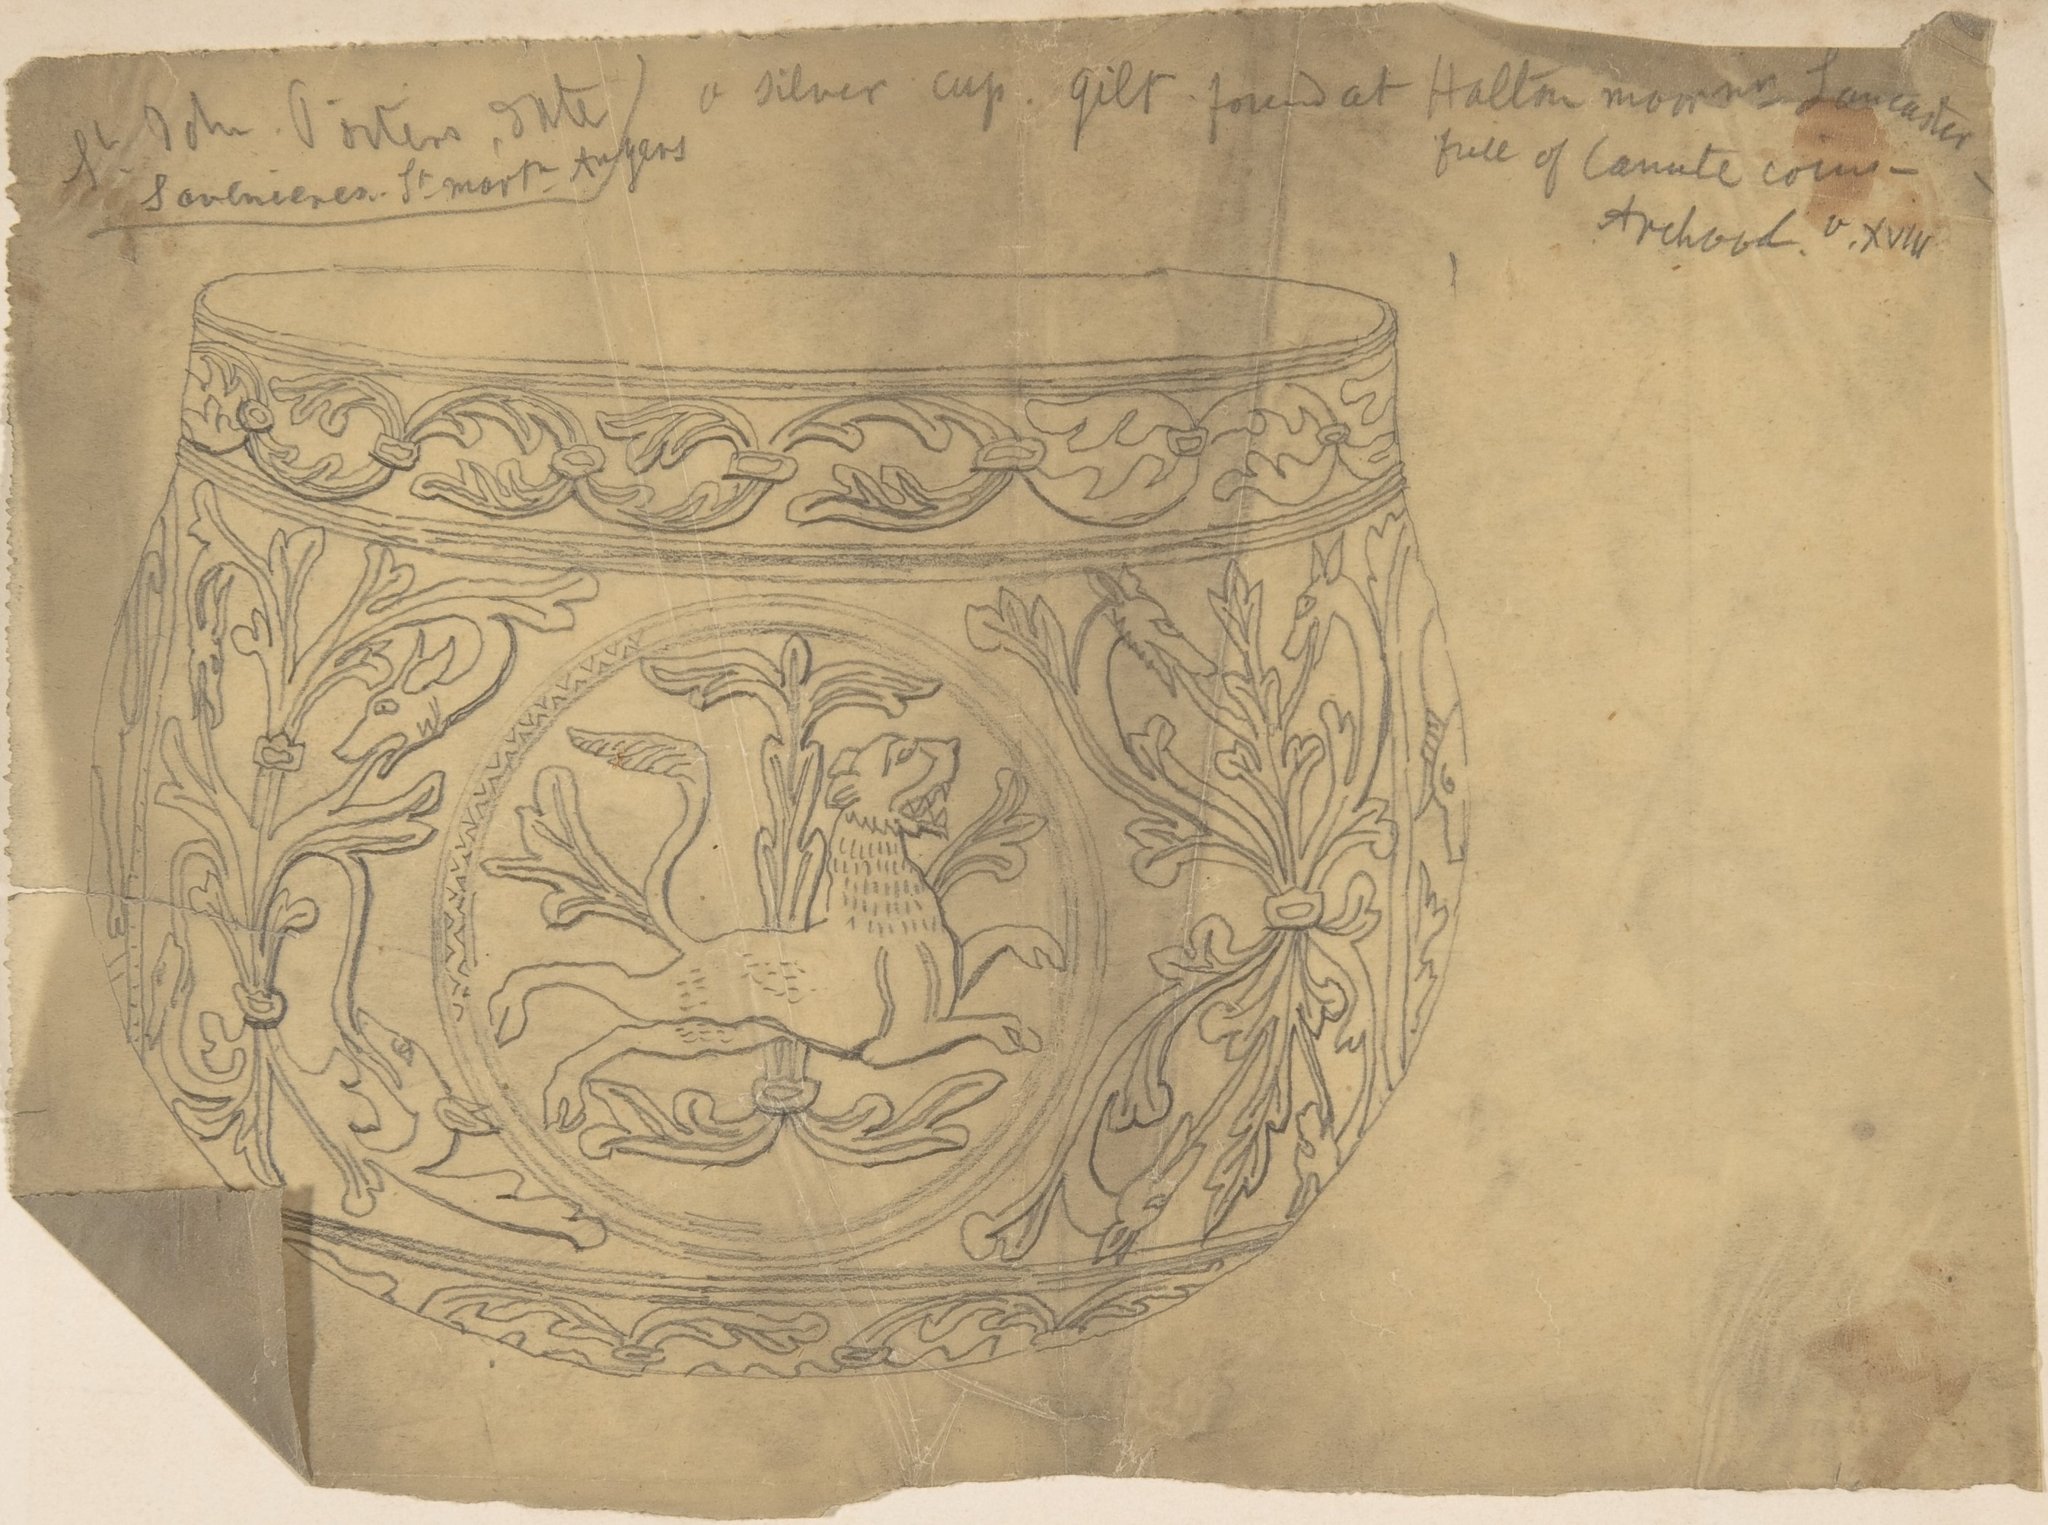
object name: drawing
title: Medieval Silver Cup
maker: anonymous, british, 19th century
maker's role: artist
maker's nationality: british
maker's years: 1800-1900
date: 1870-1900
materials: graphite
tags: lions,cups